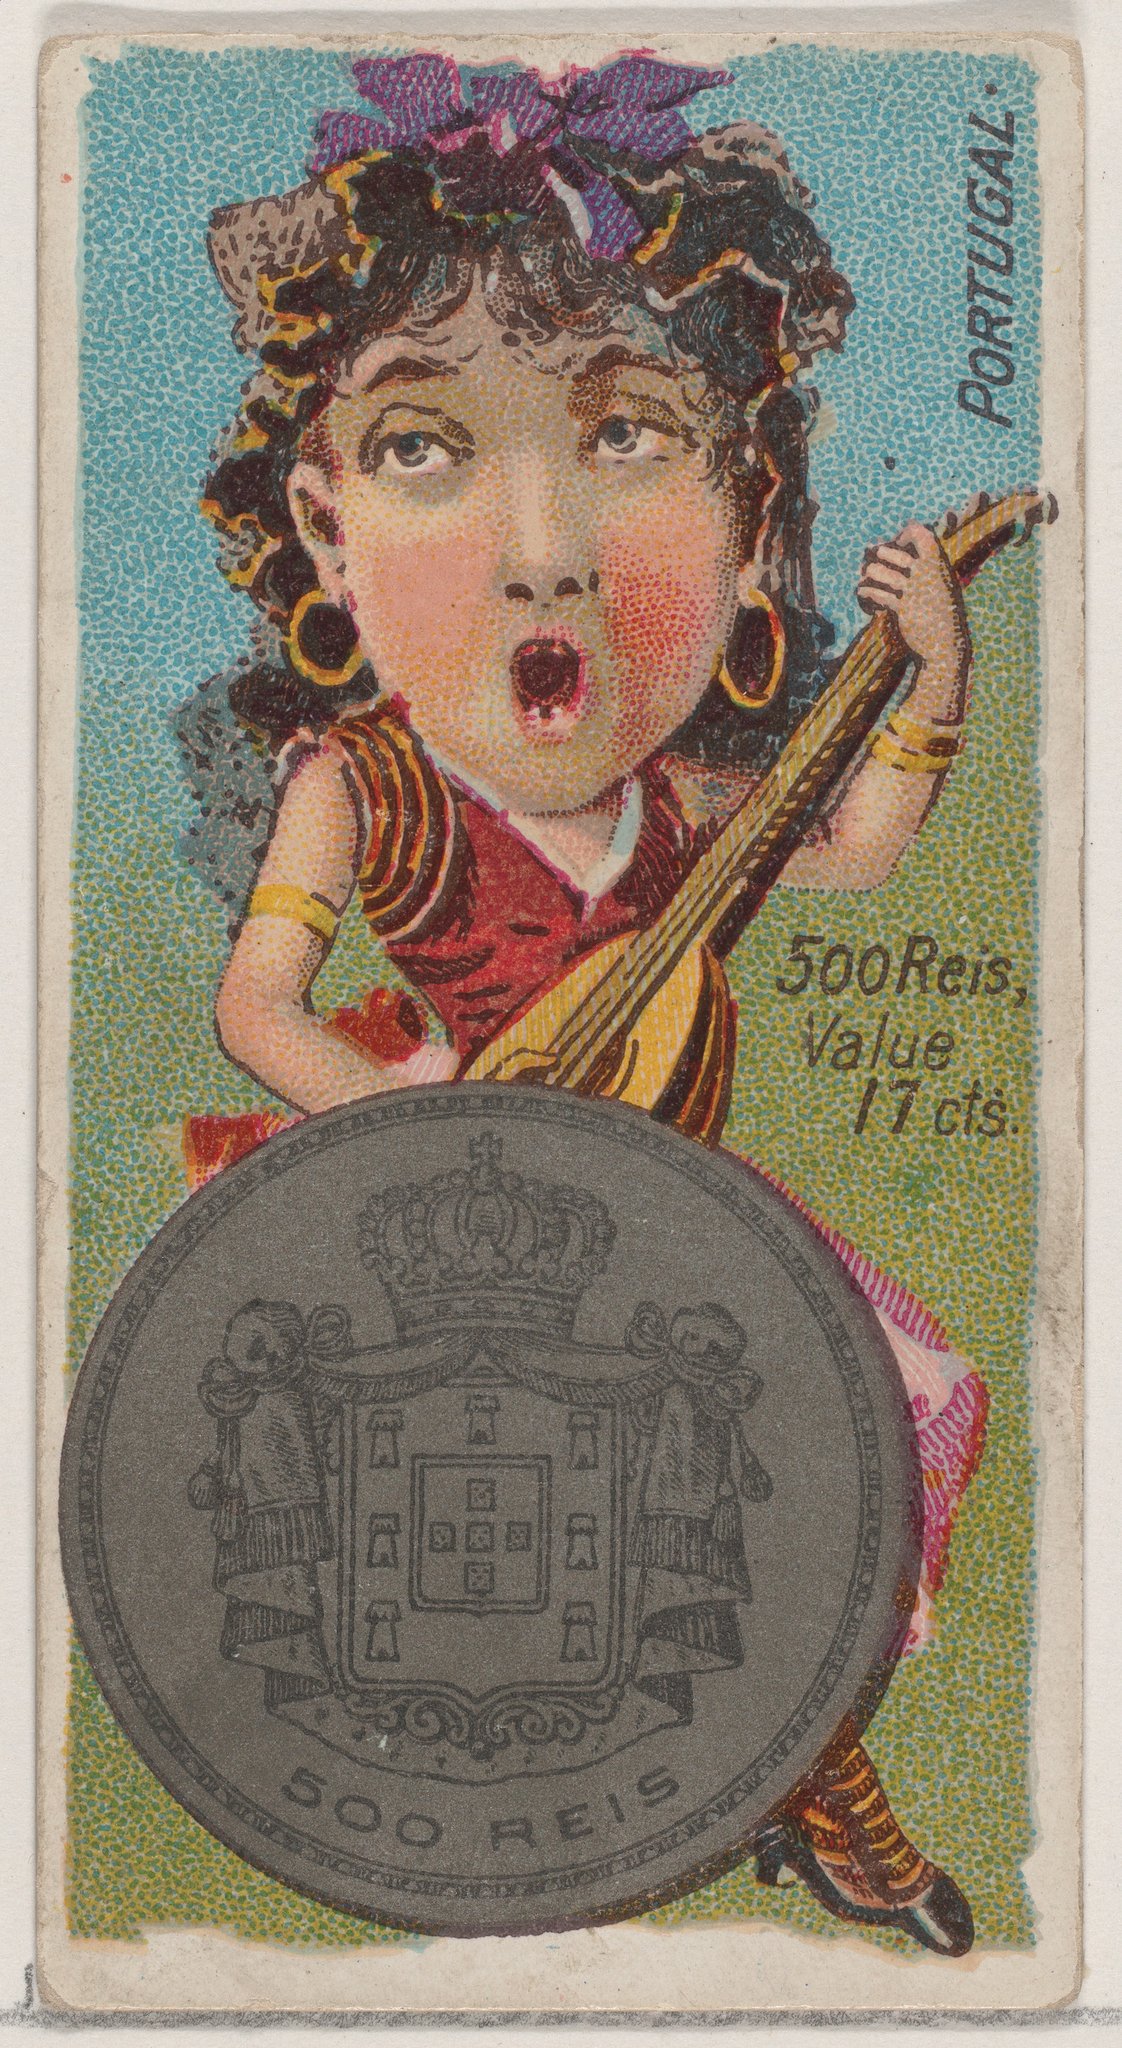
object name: print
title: Portugal, 500 Reis, from the series Coins of All Nations (N72, variation 2) for Duke brand cigarettes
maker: w. duke, sons & co.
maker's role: publisher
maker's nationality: american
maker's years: 1870-1920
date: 1889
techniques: color lithograph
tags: musical instruments,women,coins